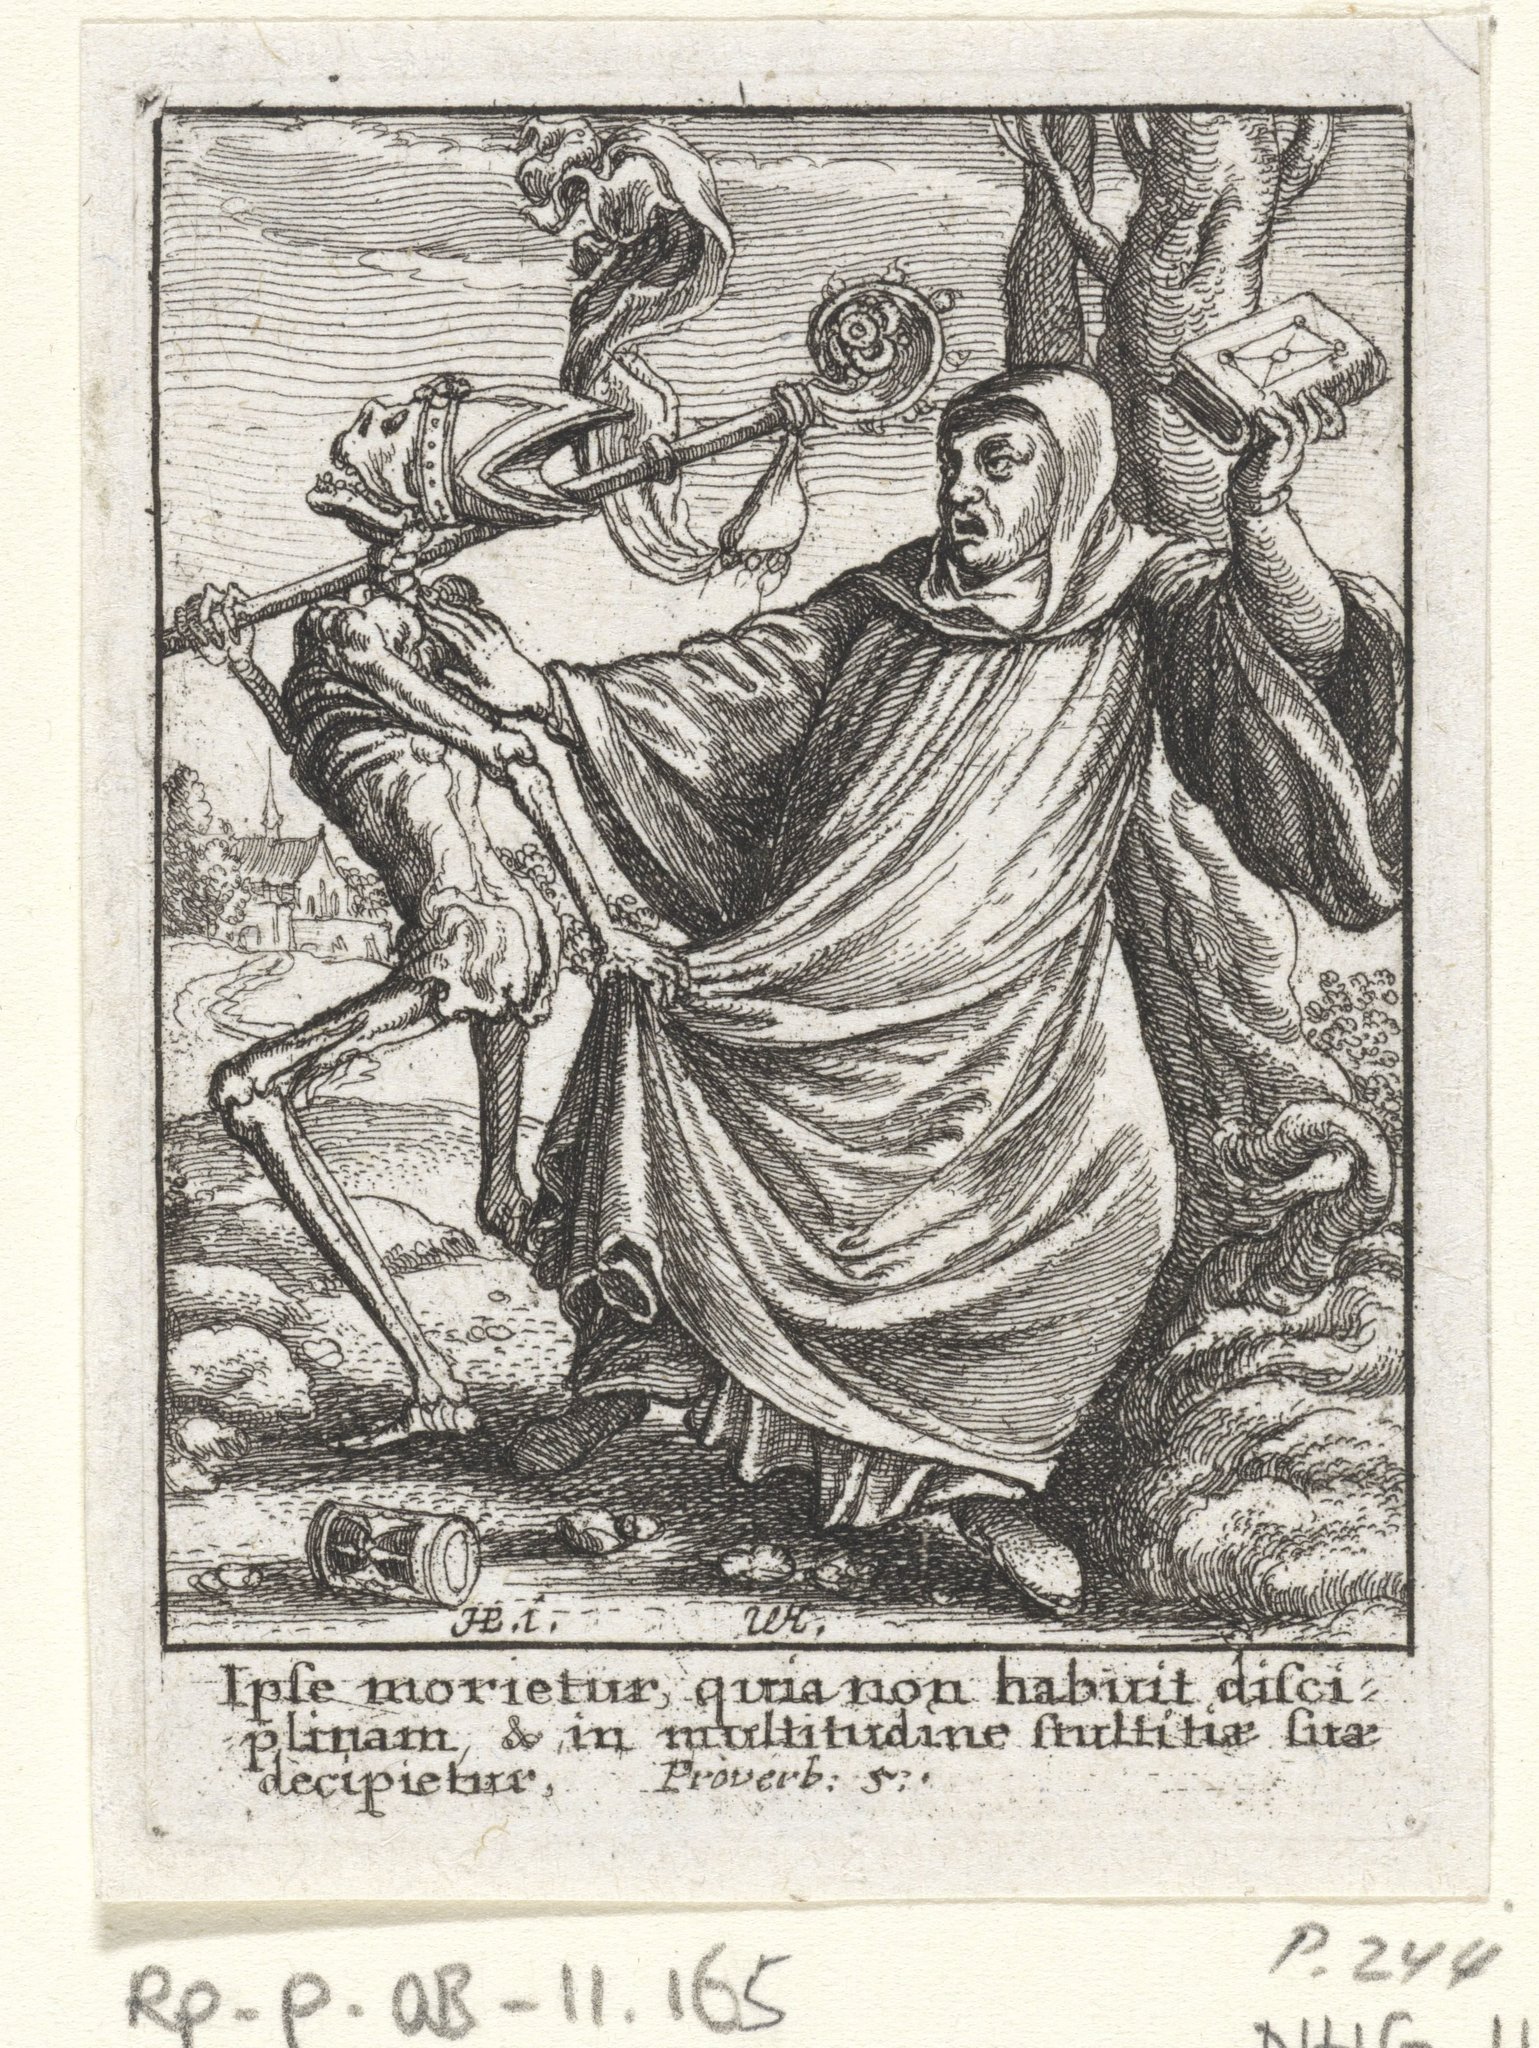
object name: book illustration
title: Dodendans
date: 1680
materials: paper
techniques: etching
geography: antwerp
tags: abbot, dance of death; death together with one or more human beings, hourglass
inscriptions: collector's mark: Lugt 240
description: Een abt wordt door de Dood aan zijn gewaad meegetrokken. De Dood is weergegeven als een bisschop met een mijter en een staf. Voor hun op de grond ligt een omgevallen zandloper.